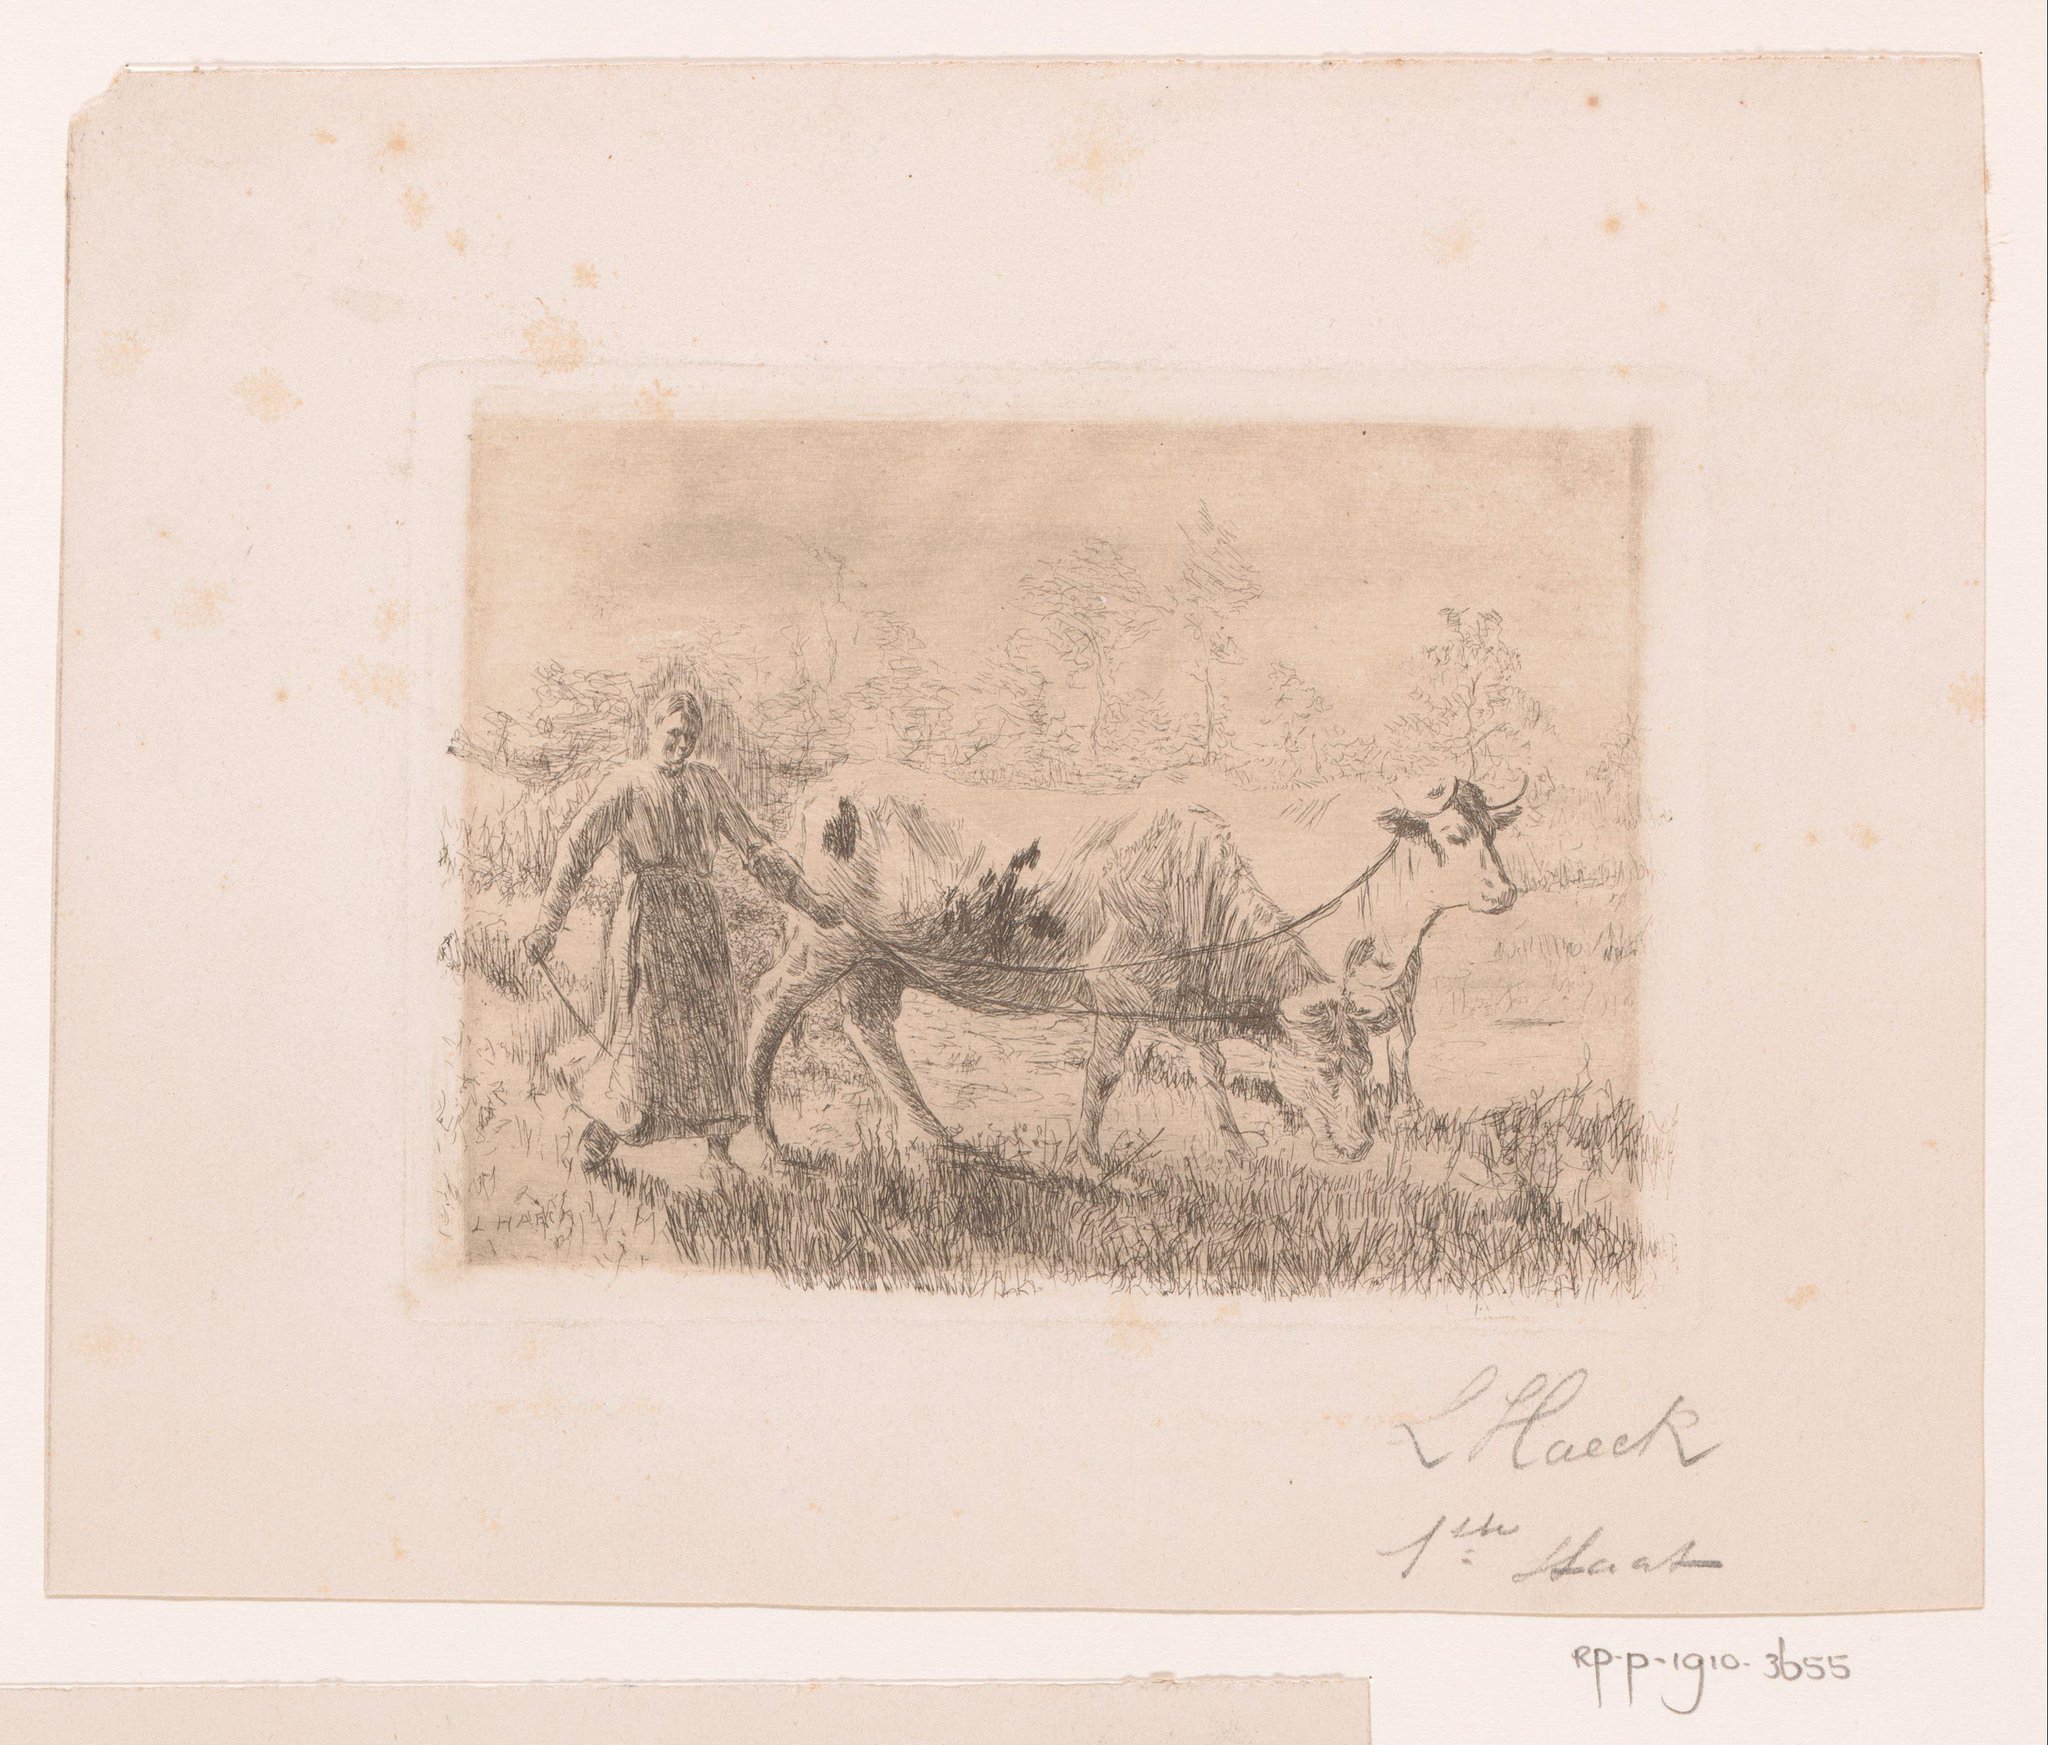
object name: print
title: Boerin leidt twee koeien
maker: léopold haeck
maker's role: painter, print maker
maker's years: 1868-1928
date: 1878-1910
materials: paper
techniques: etching, intaglio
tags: cow, farmers - aa - female farmer, farmer's wife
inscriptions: annotation: ‘1ste staat’, collector's mark: Lugt 2228